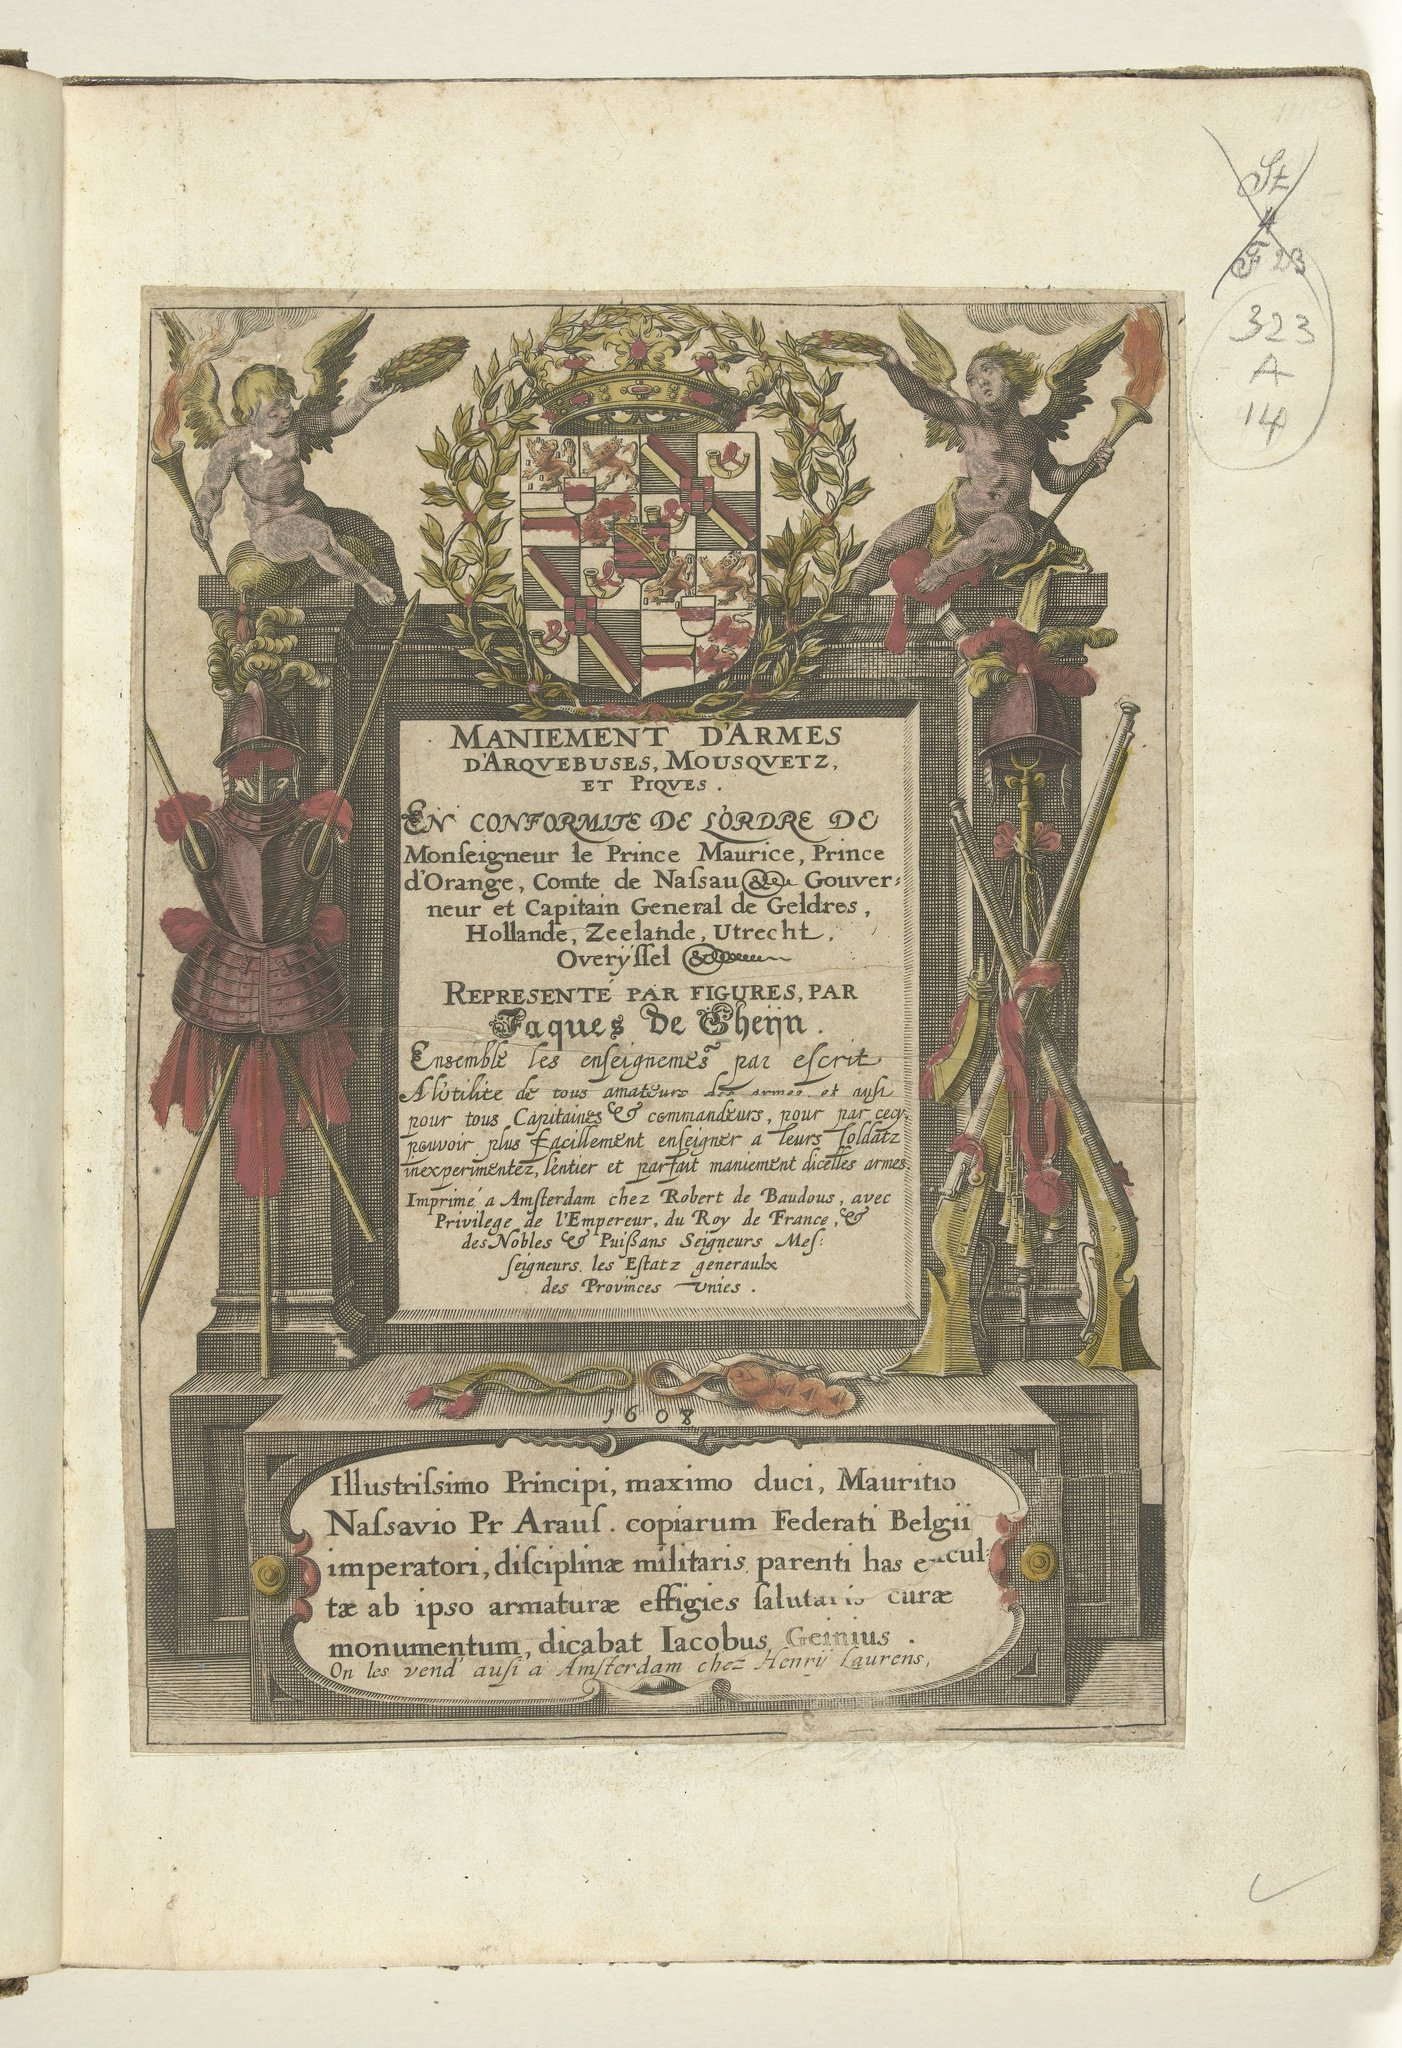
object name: titelblad, titelpagina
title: Titelpagina voor een Franse editie van Jacob de Gheyns Wapenhandelinghe van Roers Musquetten ende spiessen, 1608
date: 1608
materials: paper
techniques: engraving, hand coloring, letterpress printing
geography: amsterdam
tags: the hague, maurice (prince of orange), handling of weapons ~ military training, title-page, weapons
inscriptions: date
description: Titelpagina voor een Franse editie van Jacob de Gheyns Wapenhandelinghe van Roers Musquetten ende spiessen. Architecturale omlijsting waarop twee engeltjes aan weerszijden van het wapen van Maurits zitten, elk met een lauwerkrans in de handen. Aan weerszijden trofeeën van wapens en wapenrusting. In het midden gedrukt de Franse titel, onderaan de opdracht in het Latijn en de datum (1607 verbeterd in) 1608. Het blad uitgeknipt en opgeplakt. Onderdeel van de illustraties in een Franse editie van J. de Gheyns Wapenhandelinghe: Maniement d'armes, d'arquebuses, mousquetz et piques : en conformité de l'ordre de Mour le Prince Maurice, Prince d'Orange, Amsterdam, 1608, titelblad. Krijgswezen rond 1600.